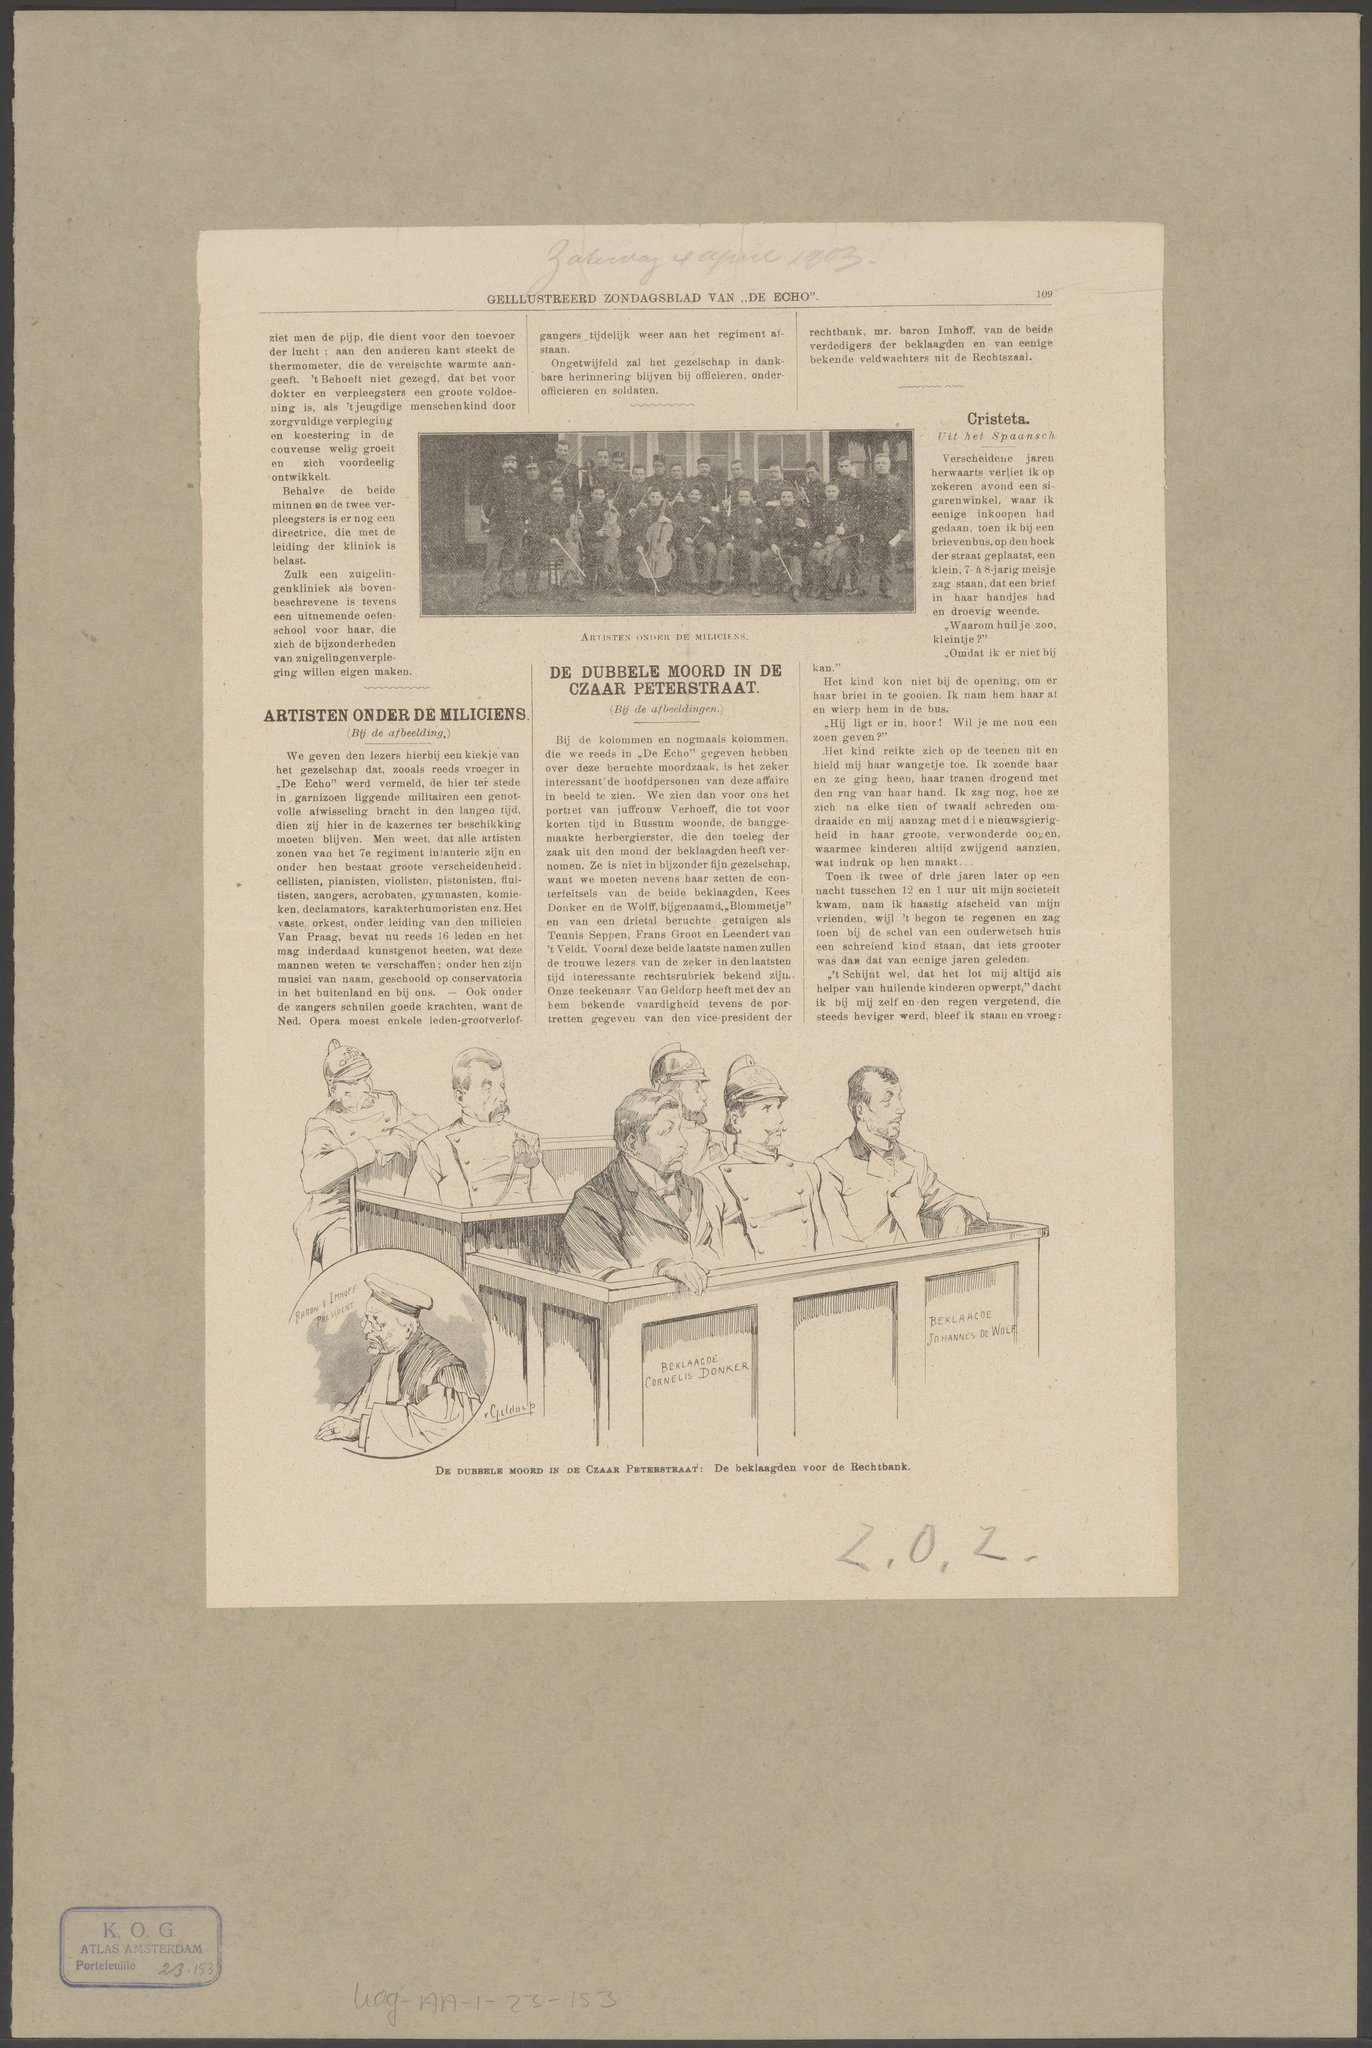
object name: photomechanical print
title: De dubbele moord in de Czaar Peterstraat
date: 1903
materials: paper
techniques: letterpress printing, line block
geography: netherlands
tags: amsterdam, painter, administration of justice, trial, policeman, constable, law and jurisprudence (+ judge)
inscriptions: collector's mark: Lugt 1641b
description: Prent uit: Geïllustreerd Zondagsblad van "De Echo", 4 april 1903.